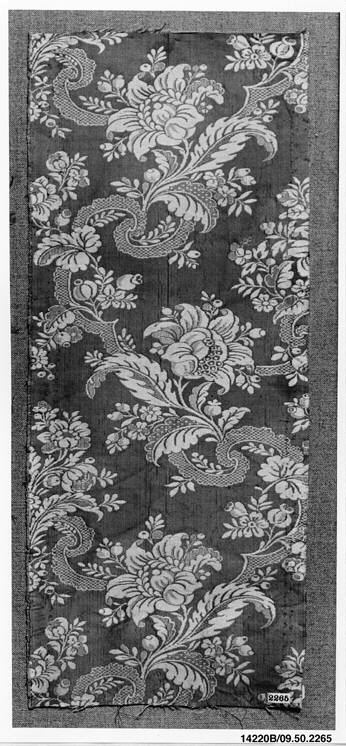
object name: piece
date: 1730-1735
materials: silk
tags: flowers,leaves